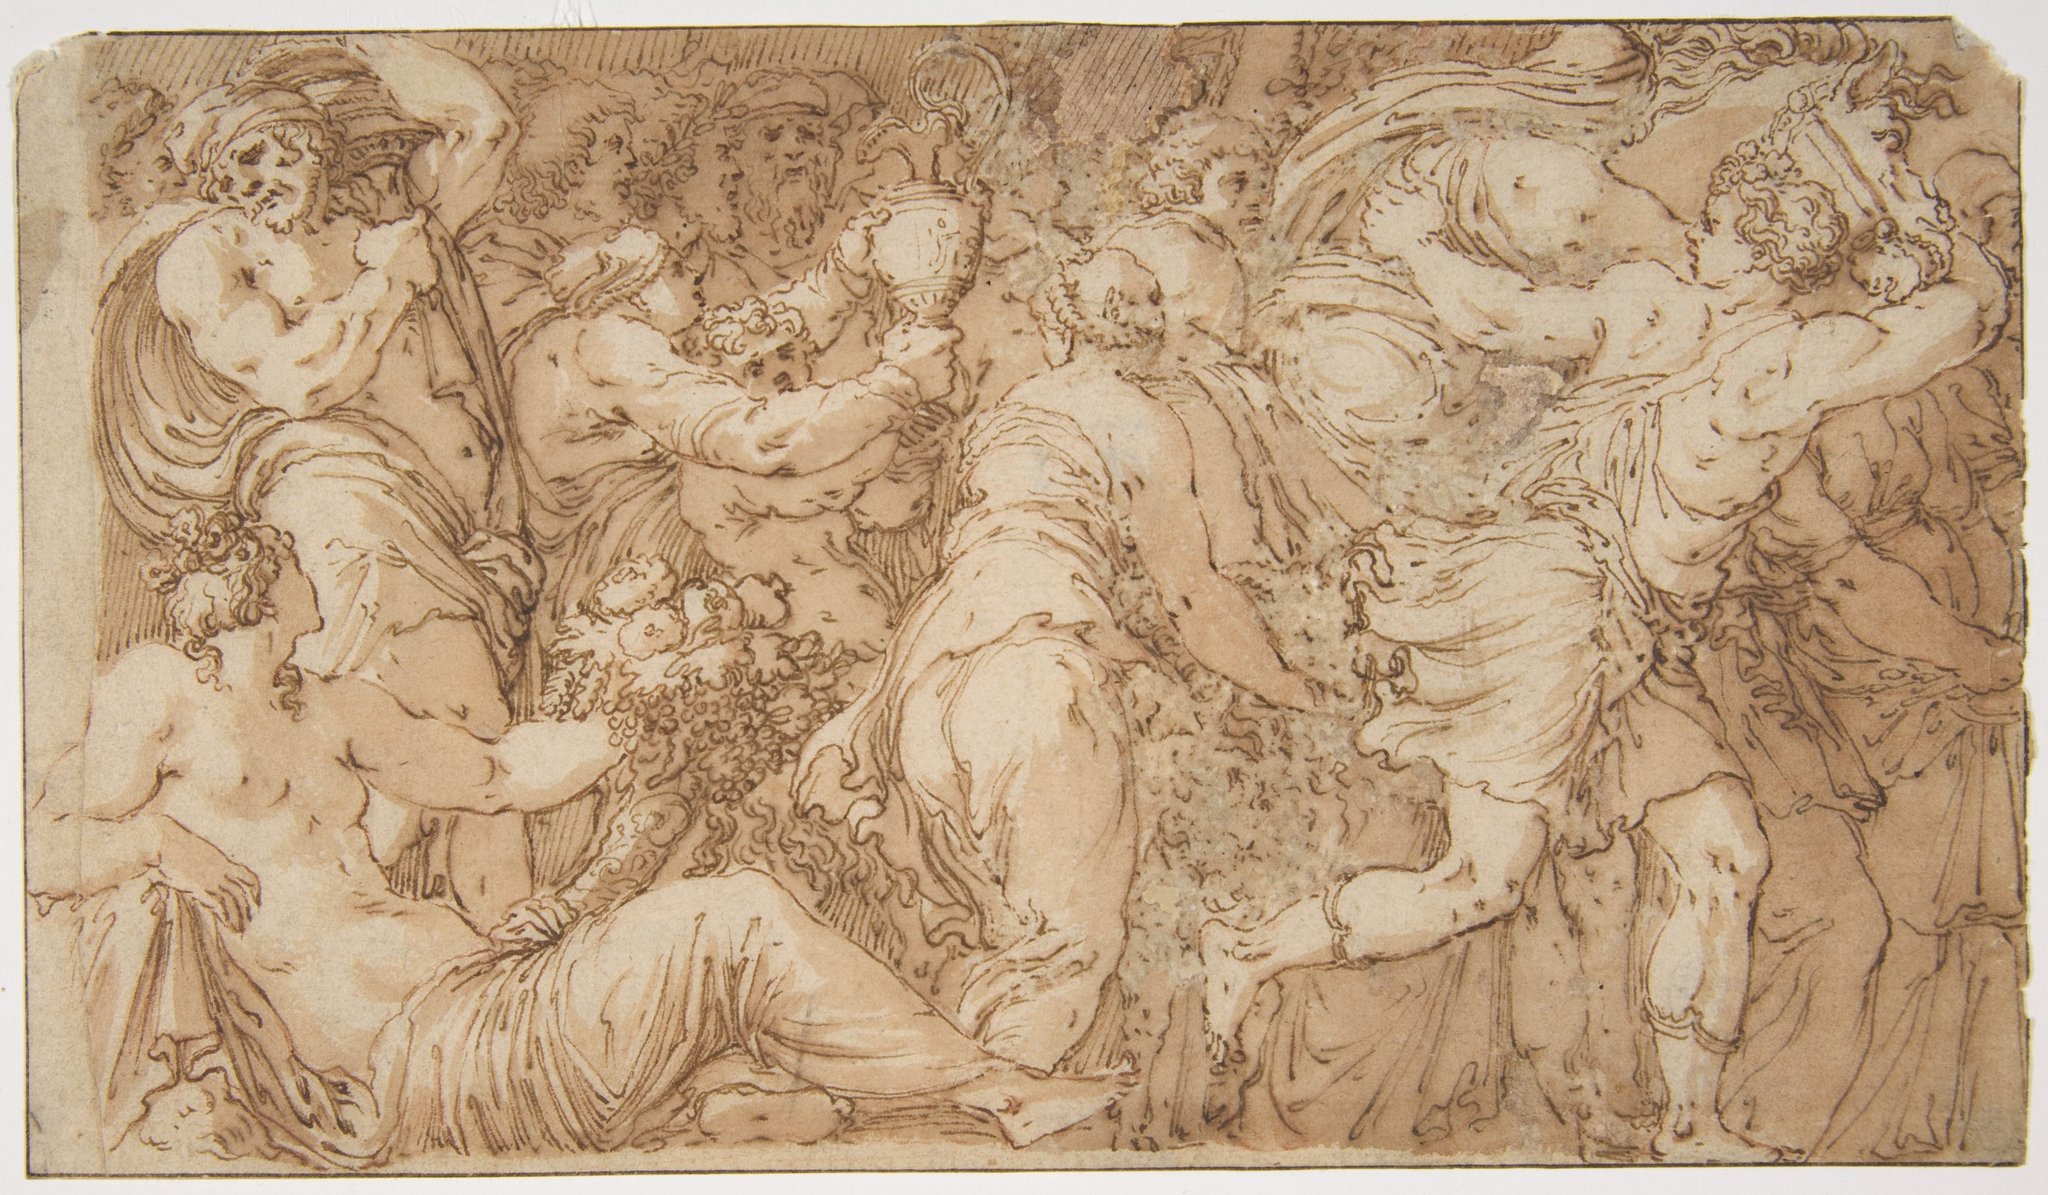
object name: drawing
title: Festival Procession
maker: polidoro da caravaggio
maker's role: artist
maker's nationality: italian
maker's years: 1494-1548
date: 1499-1543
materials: ink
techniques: brush, pen, wash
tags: men,crowd